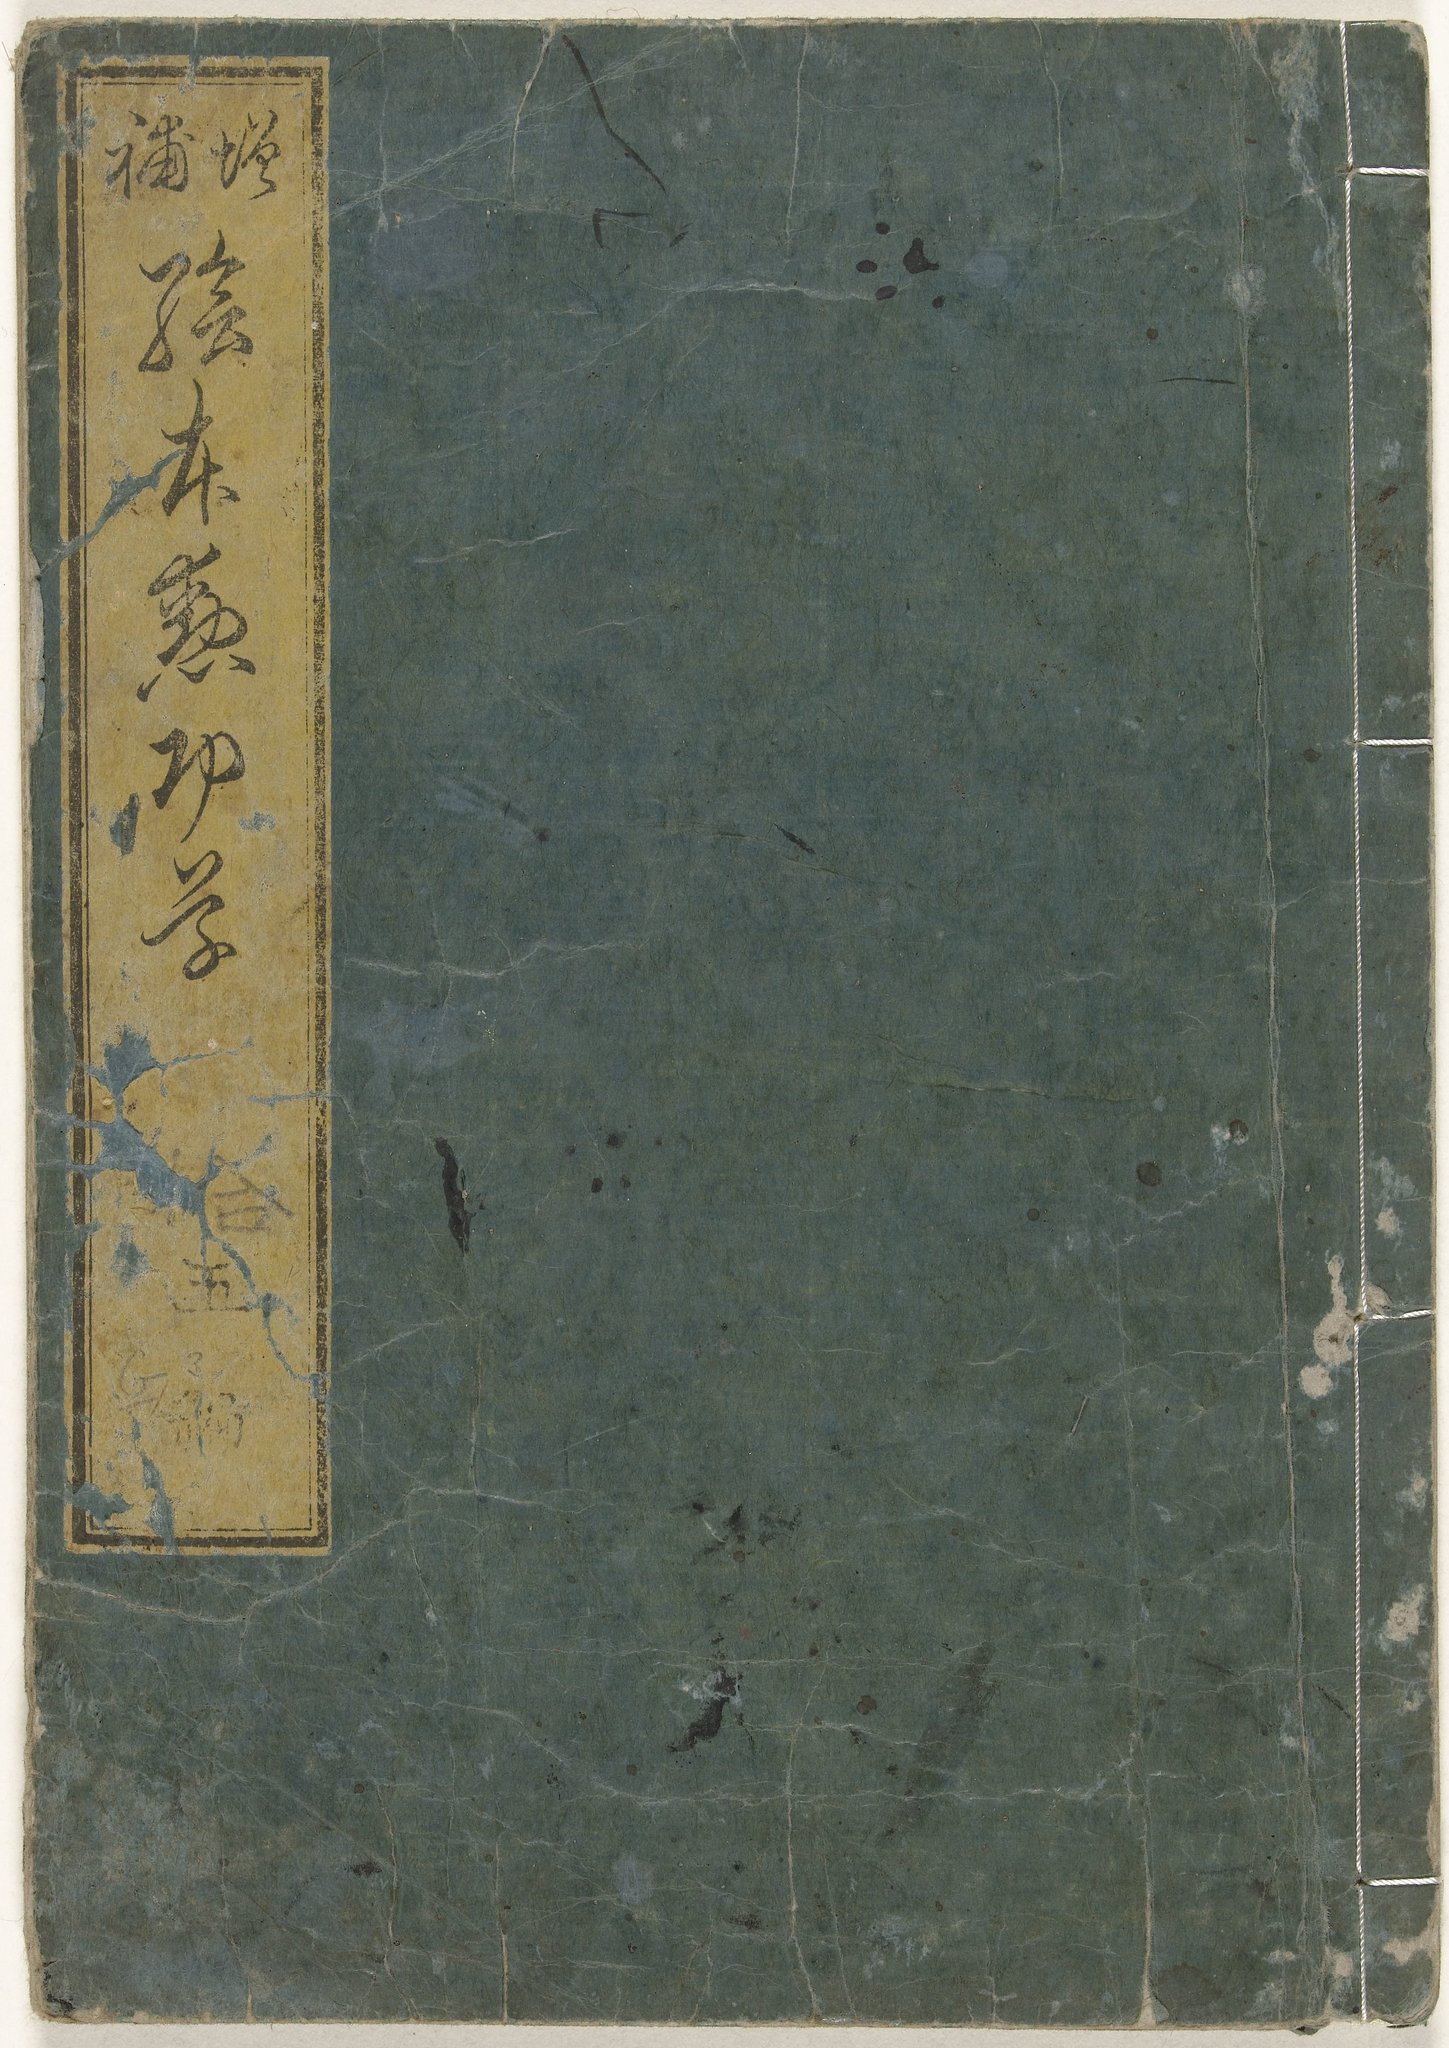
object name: book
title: Zoho ehon isaoshigusa - gohen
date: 1840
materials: paper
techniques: woodcut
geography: edo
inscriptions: collector's mark: Lugt 2228